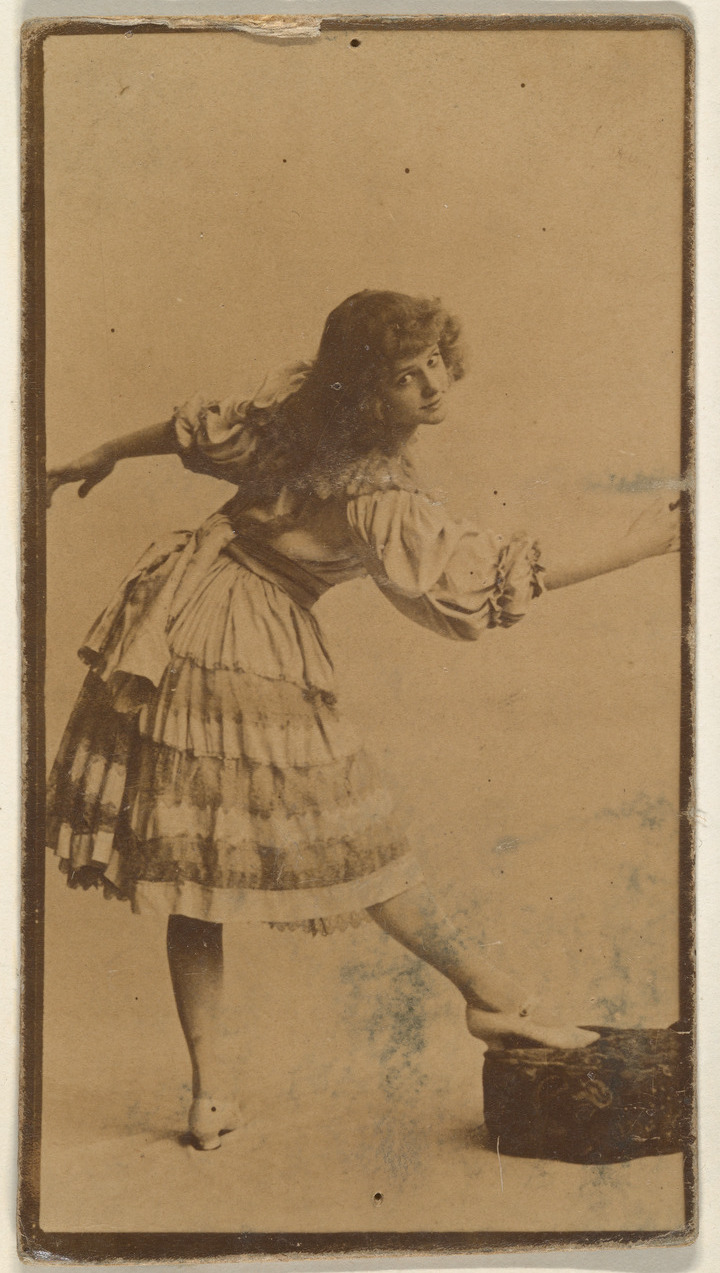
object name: photograph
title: Actress posing with foot on cushion, from the Actresses series (N668)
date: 1888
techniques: albumen silver print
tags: portraits,women,actresses